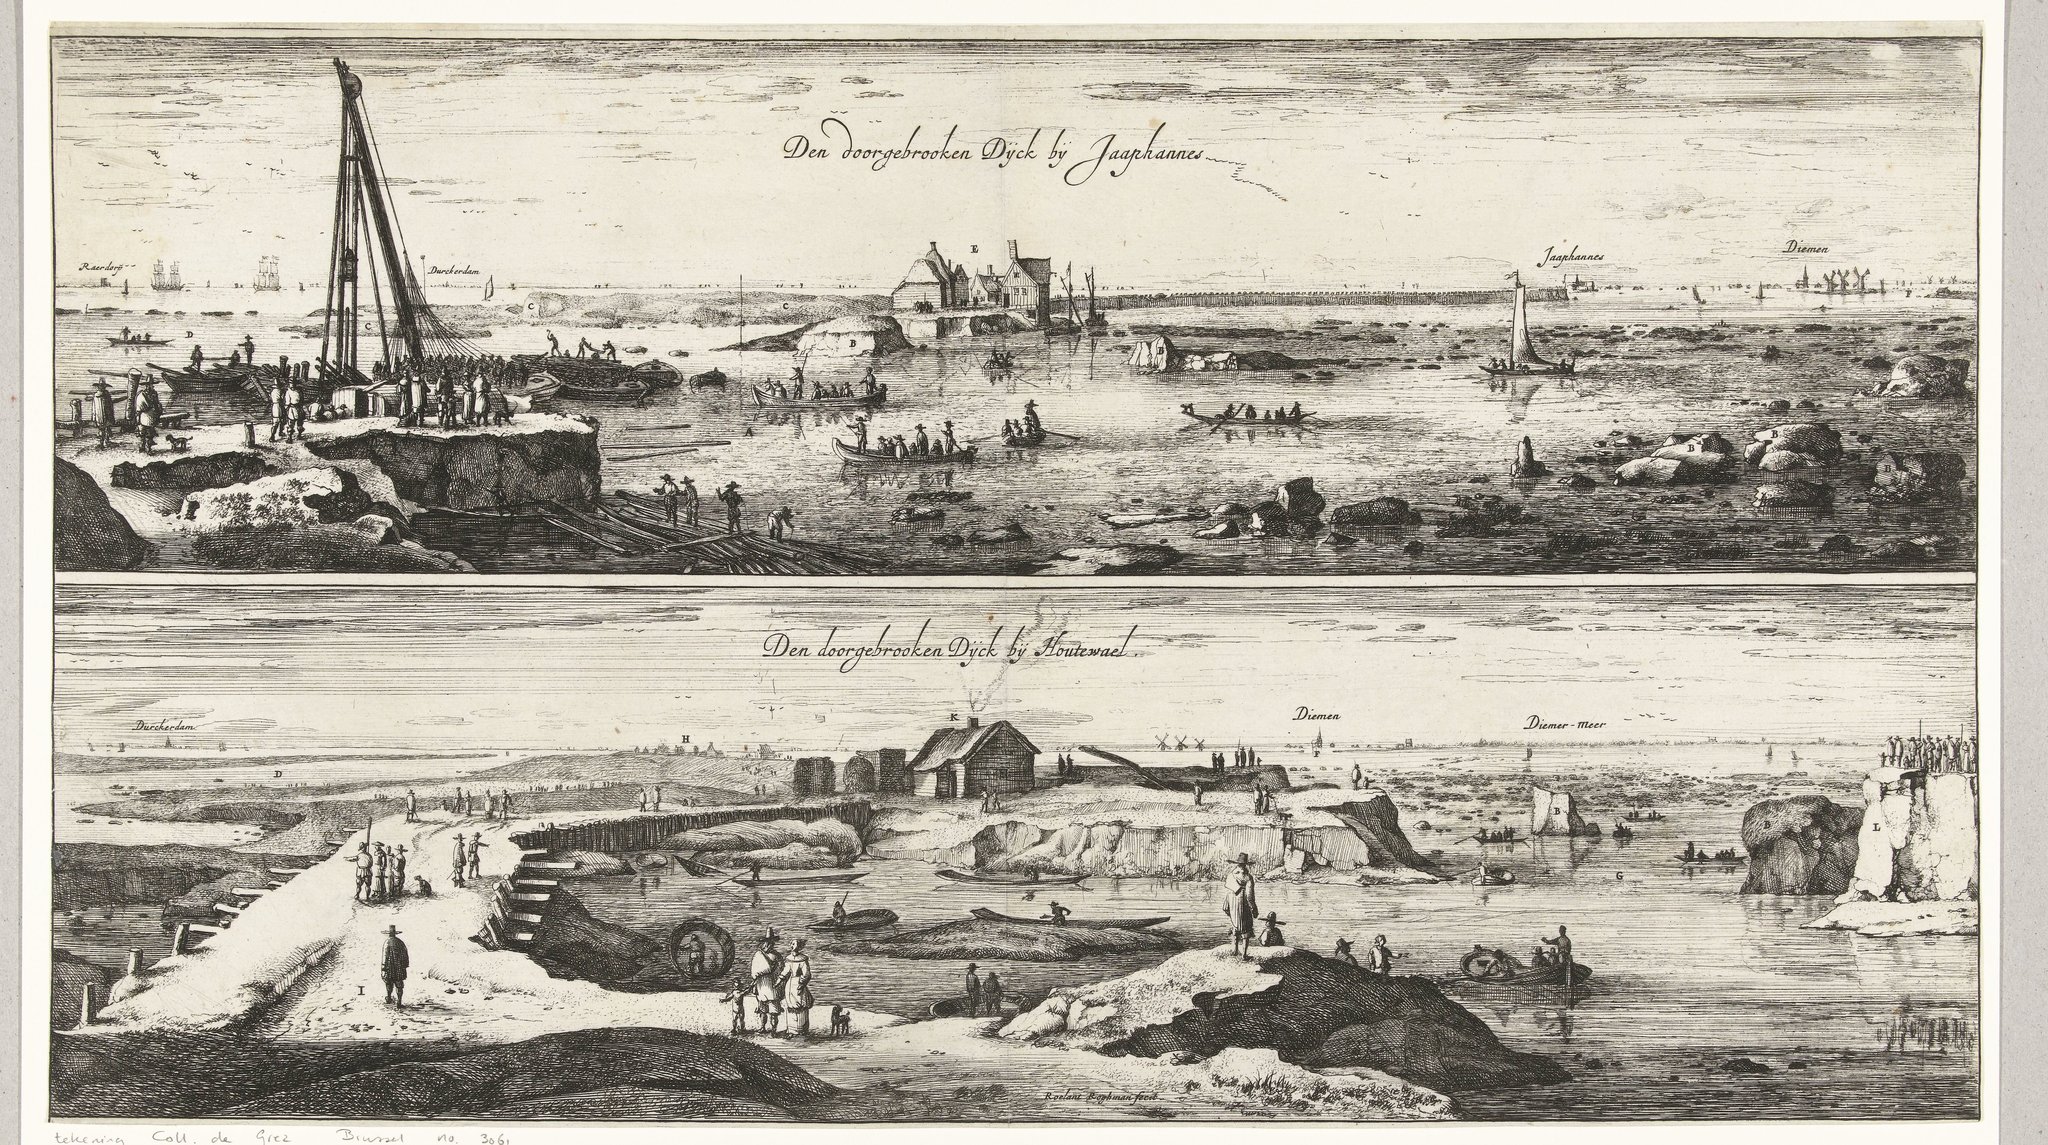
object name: print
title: The Breached Dike at Jaap Hannes and Houtewael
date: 1651-1652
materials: paper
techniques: etching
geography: amsterdam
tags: dike-break, building activities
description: Repairs to the dike begun some time after the disaster. In the left foreground of the upper print is a pile driver, and at the right are fragments of the burst dike. At the left of the lower print can be discerned the temporary dam put up behind the dike, and in the middle the canteen of the recovery workers.